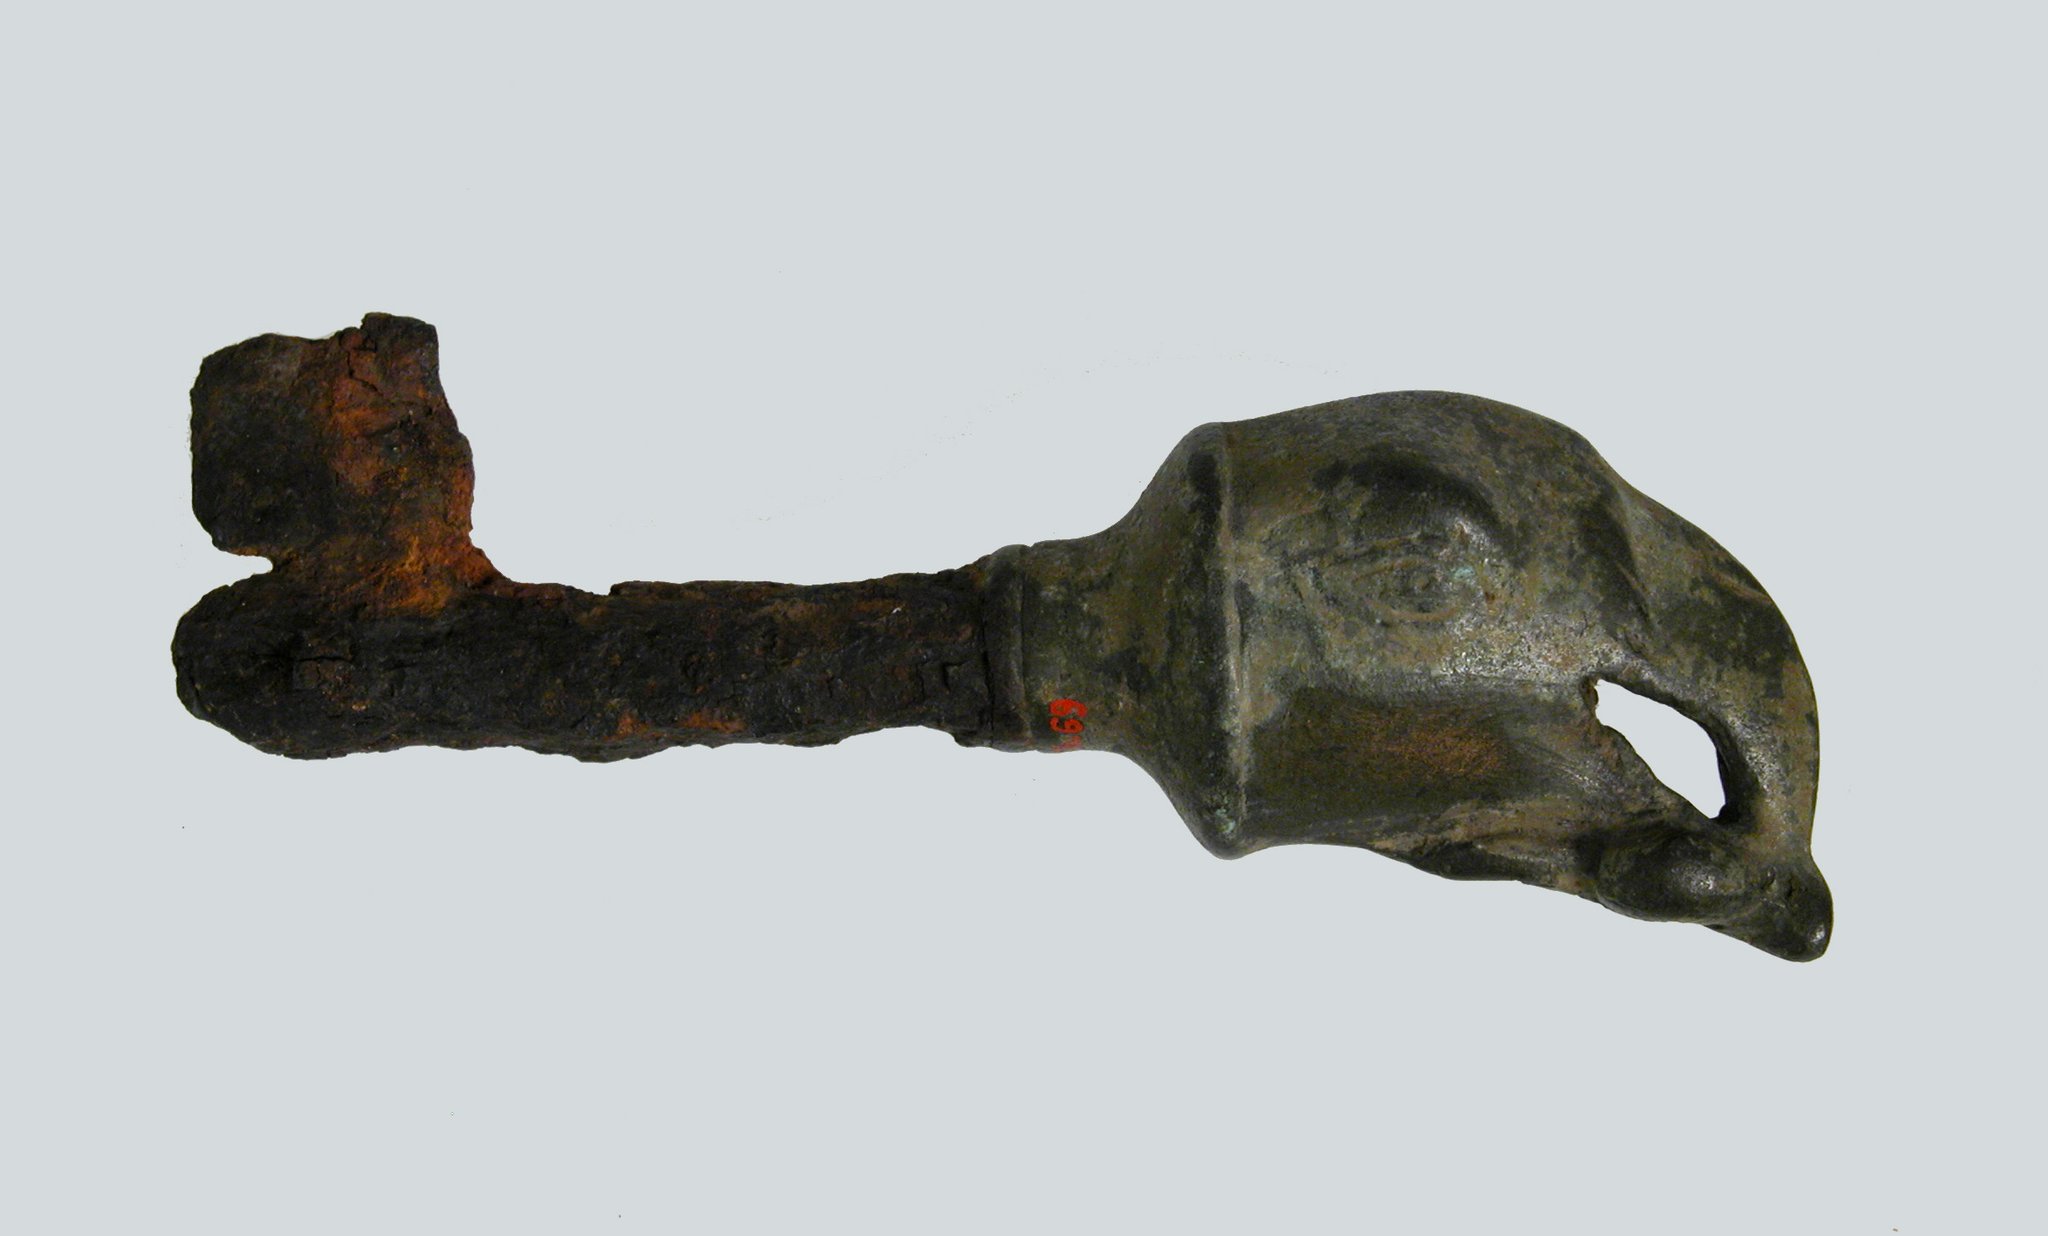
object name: key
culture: roman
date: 1-700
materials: copper alloy, iron